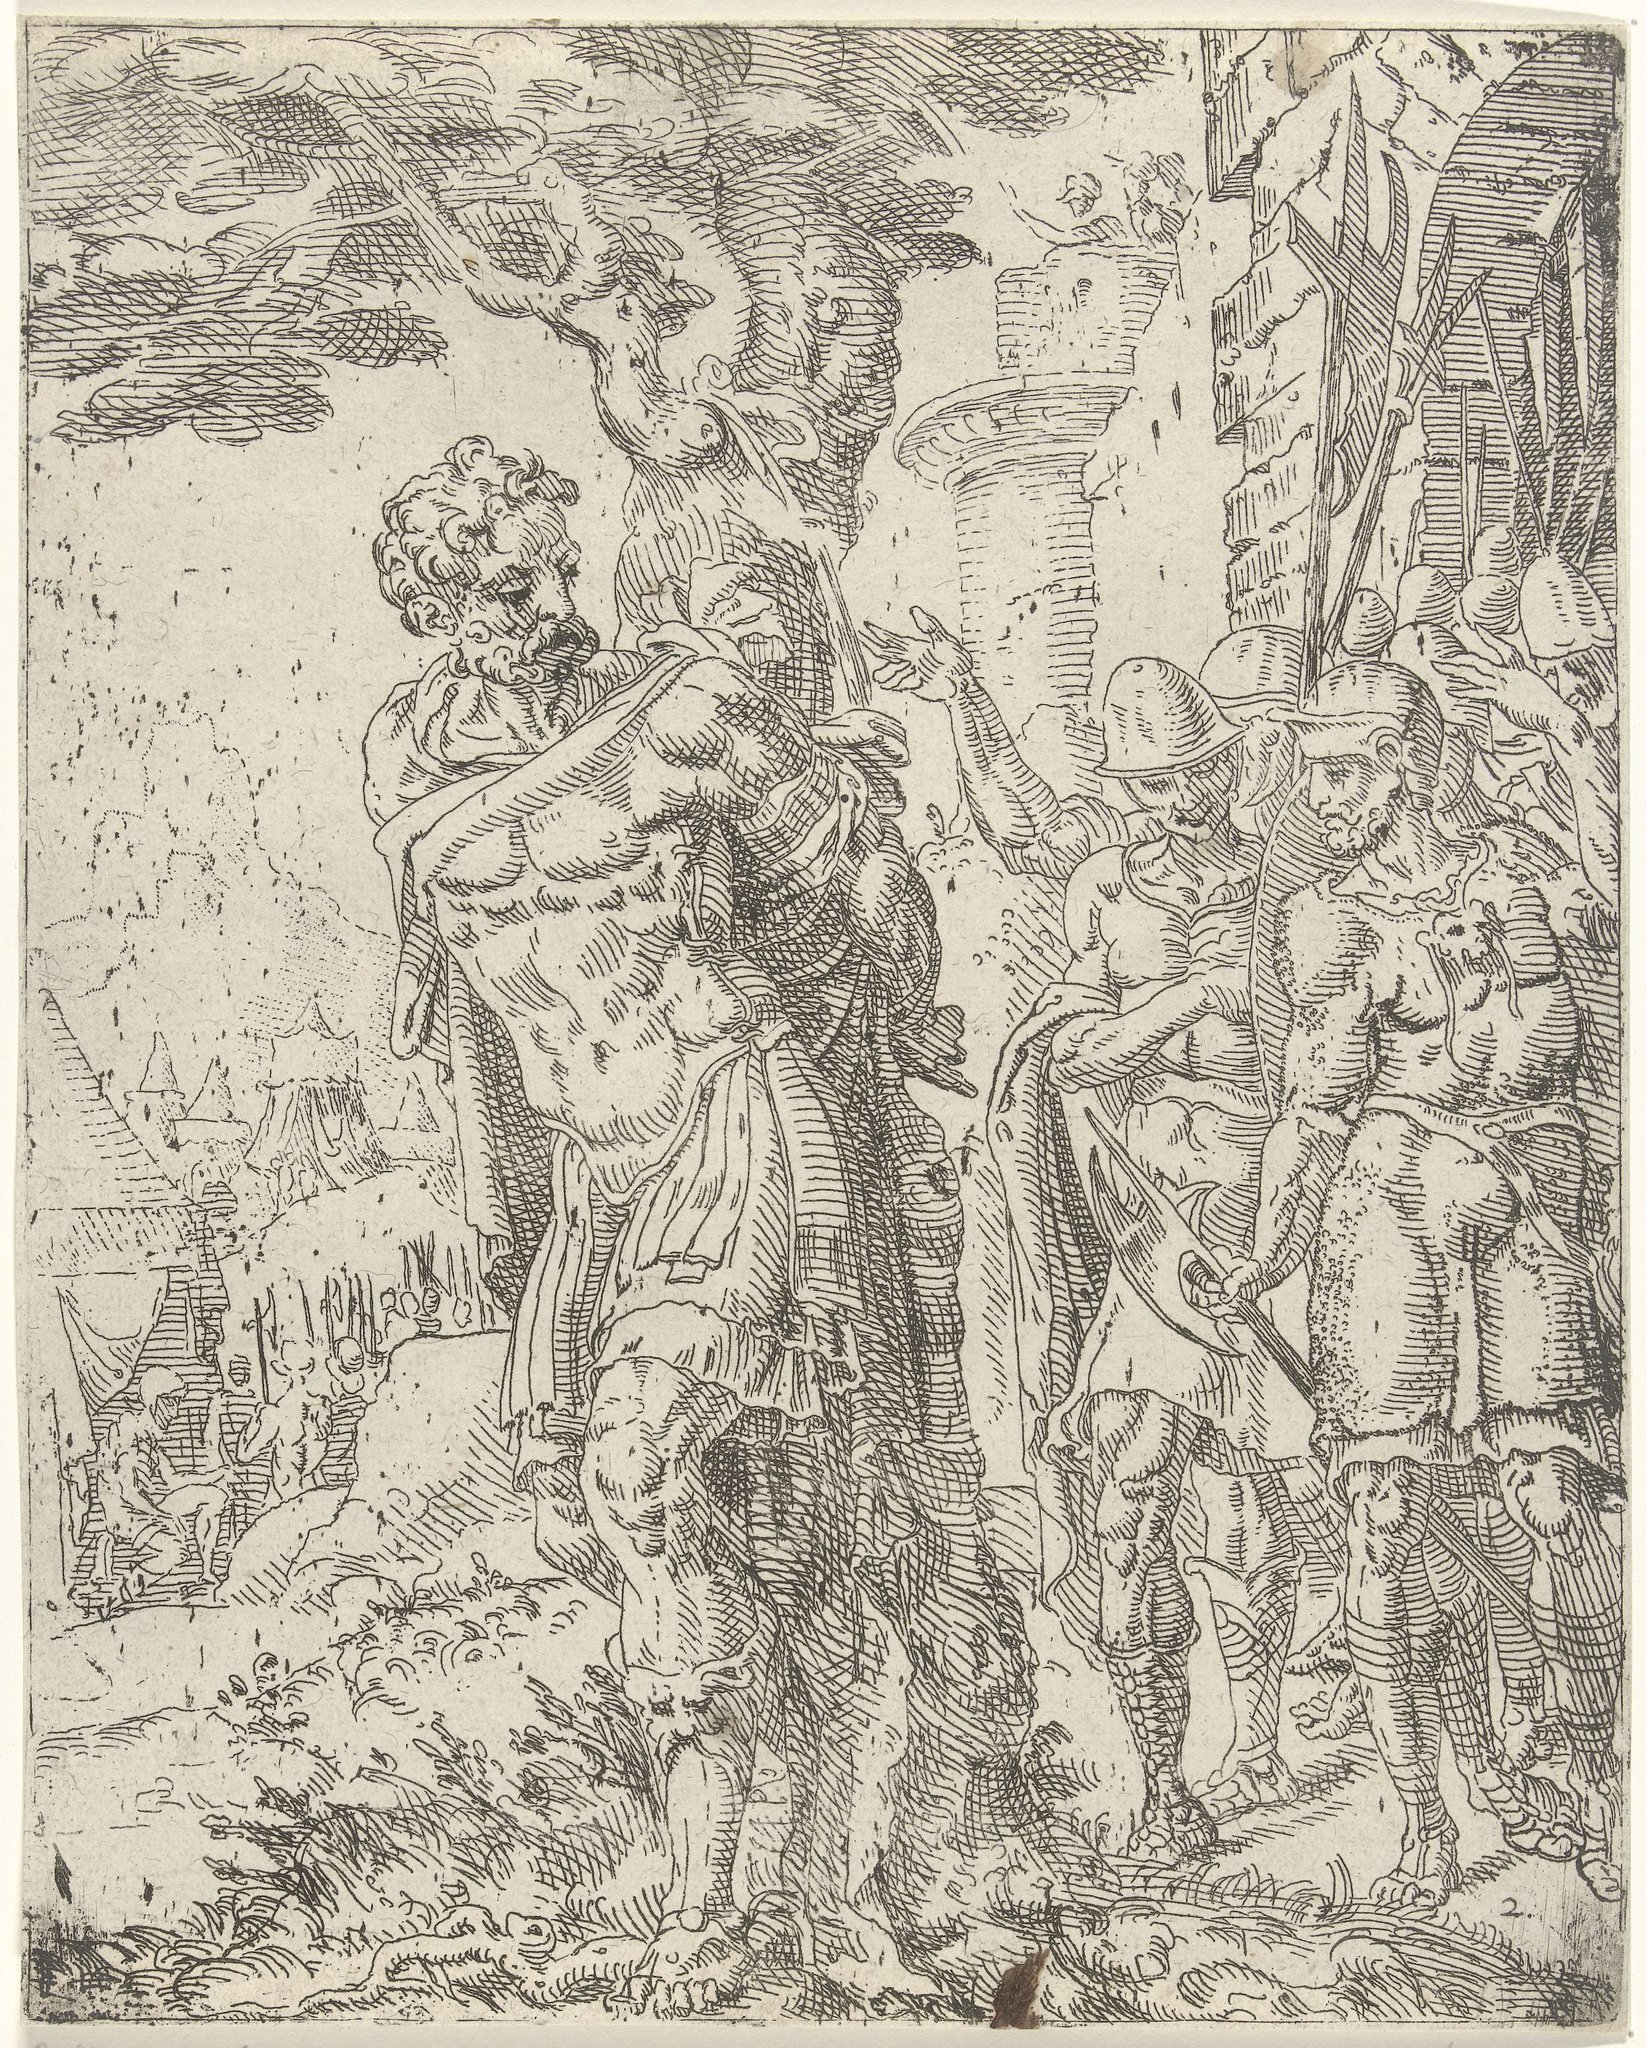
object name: print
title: Judit en Holofernes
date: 1547-1559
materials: paper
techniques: etching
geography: haarlem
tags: achior is tied to a tree near the city of bethuliah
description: Achior, de aanvoerder van de Ammonieten, is vastgebonden aan een boom. Hij werd door Holofernes gestraft omwille van zijn prijzende woorden over de Israëlieten. De Israëlieten zien hem en komen de man bevrijden. De prent maakt deel uit van een achtdelige serie die het verhaal vertelt van Judit en Holofernes.